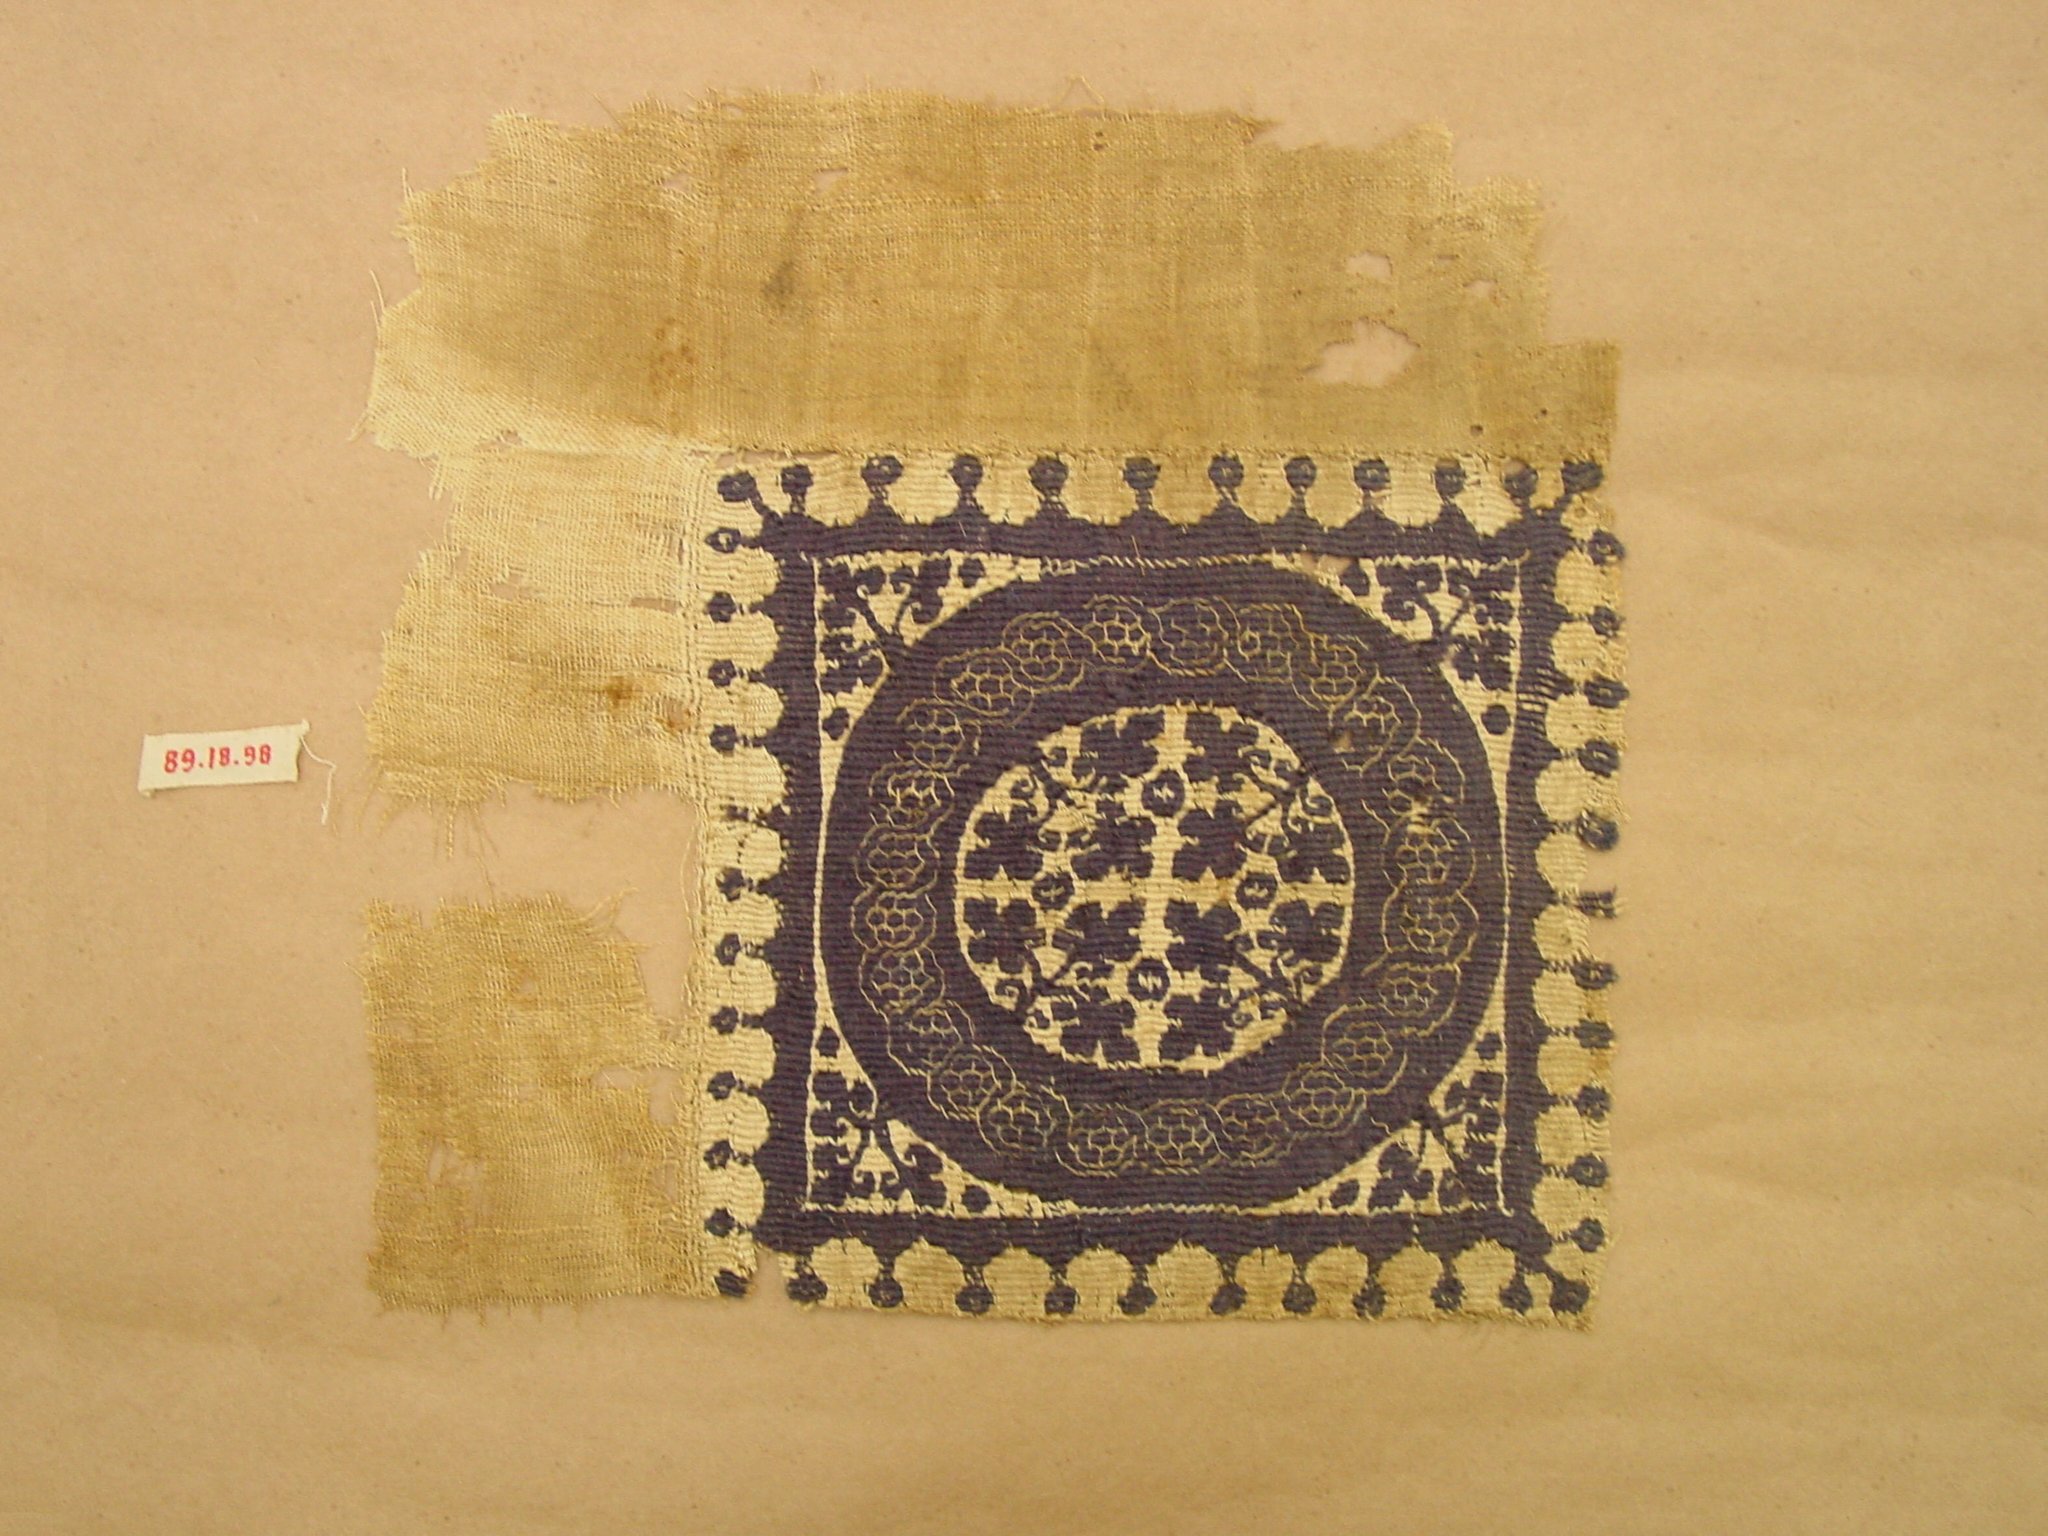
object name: textile fragment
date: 201-400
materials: linen, wool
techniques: weave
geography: egypt